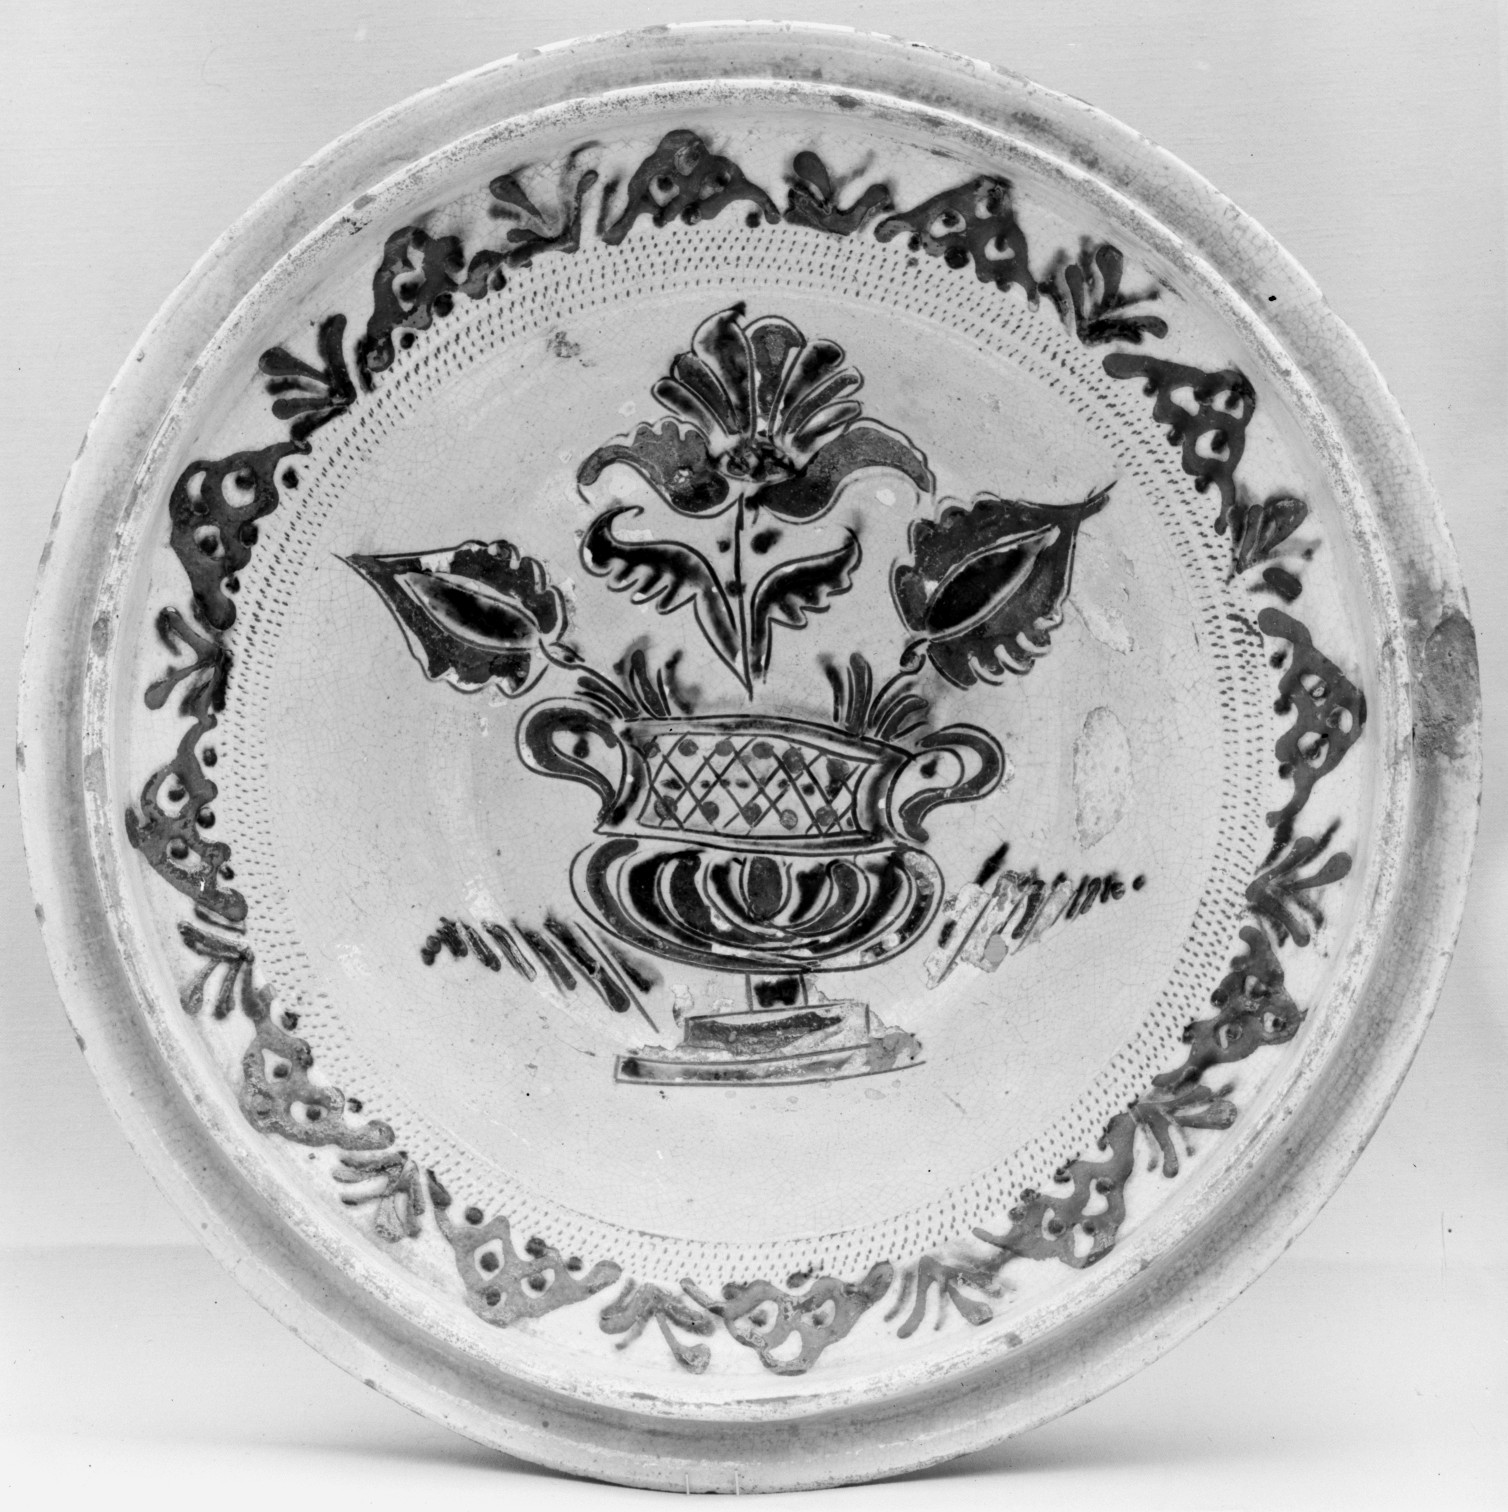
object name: plate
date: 1701-1800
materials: pottery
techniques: glazing